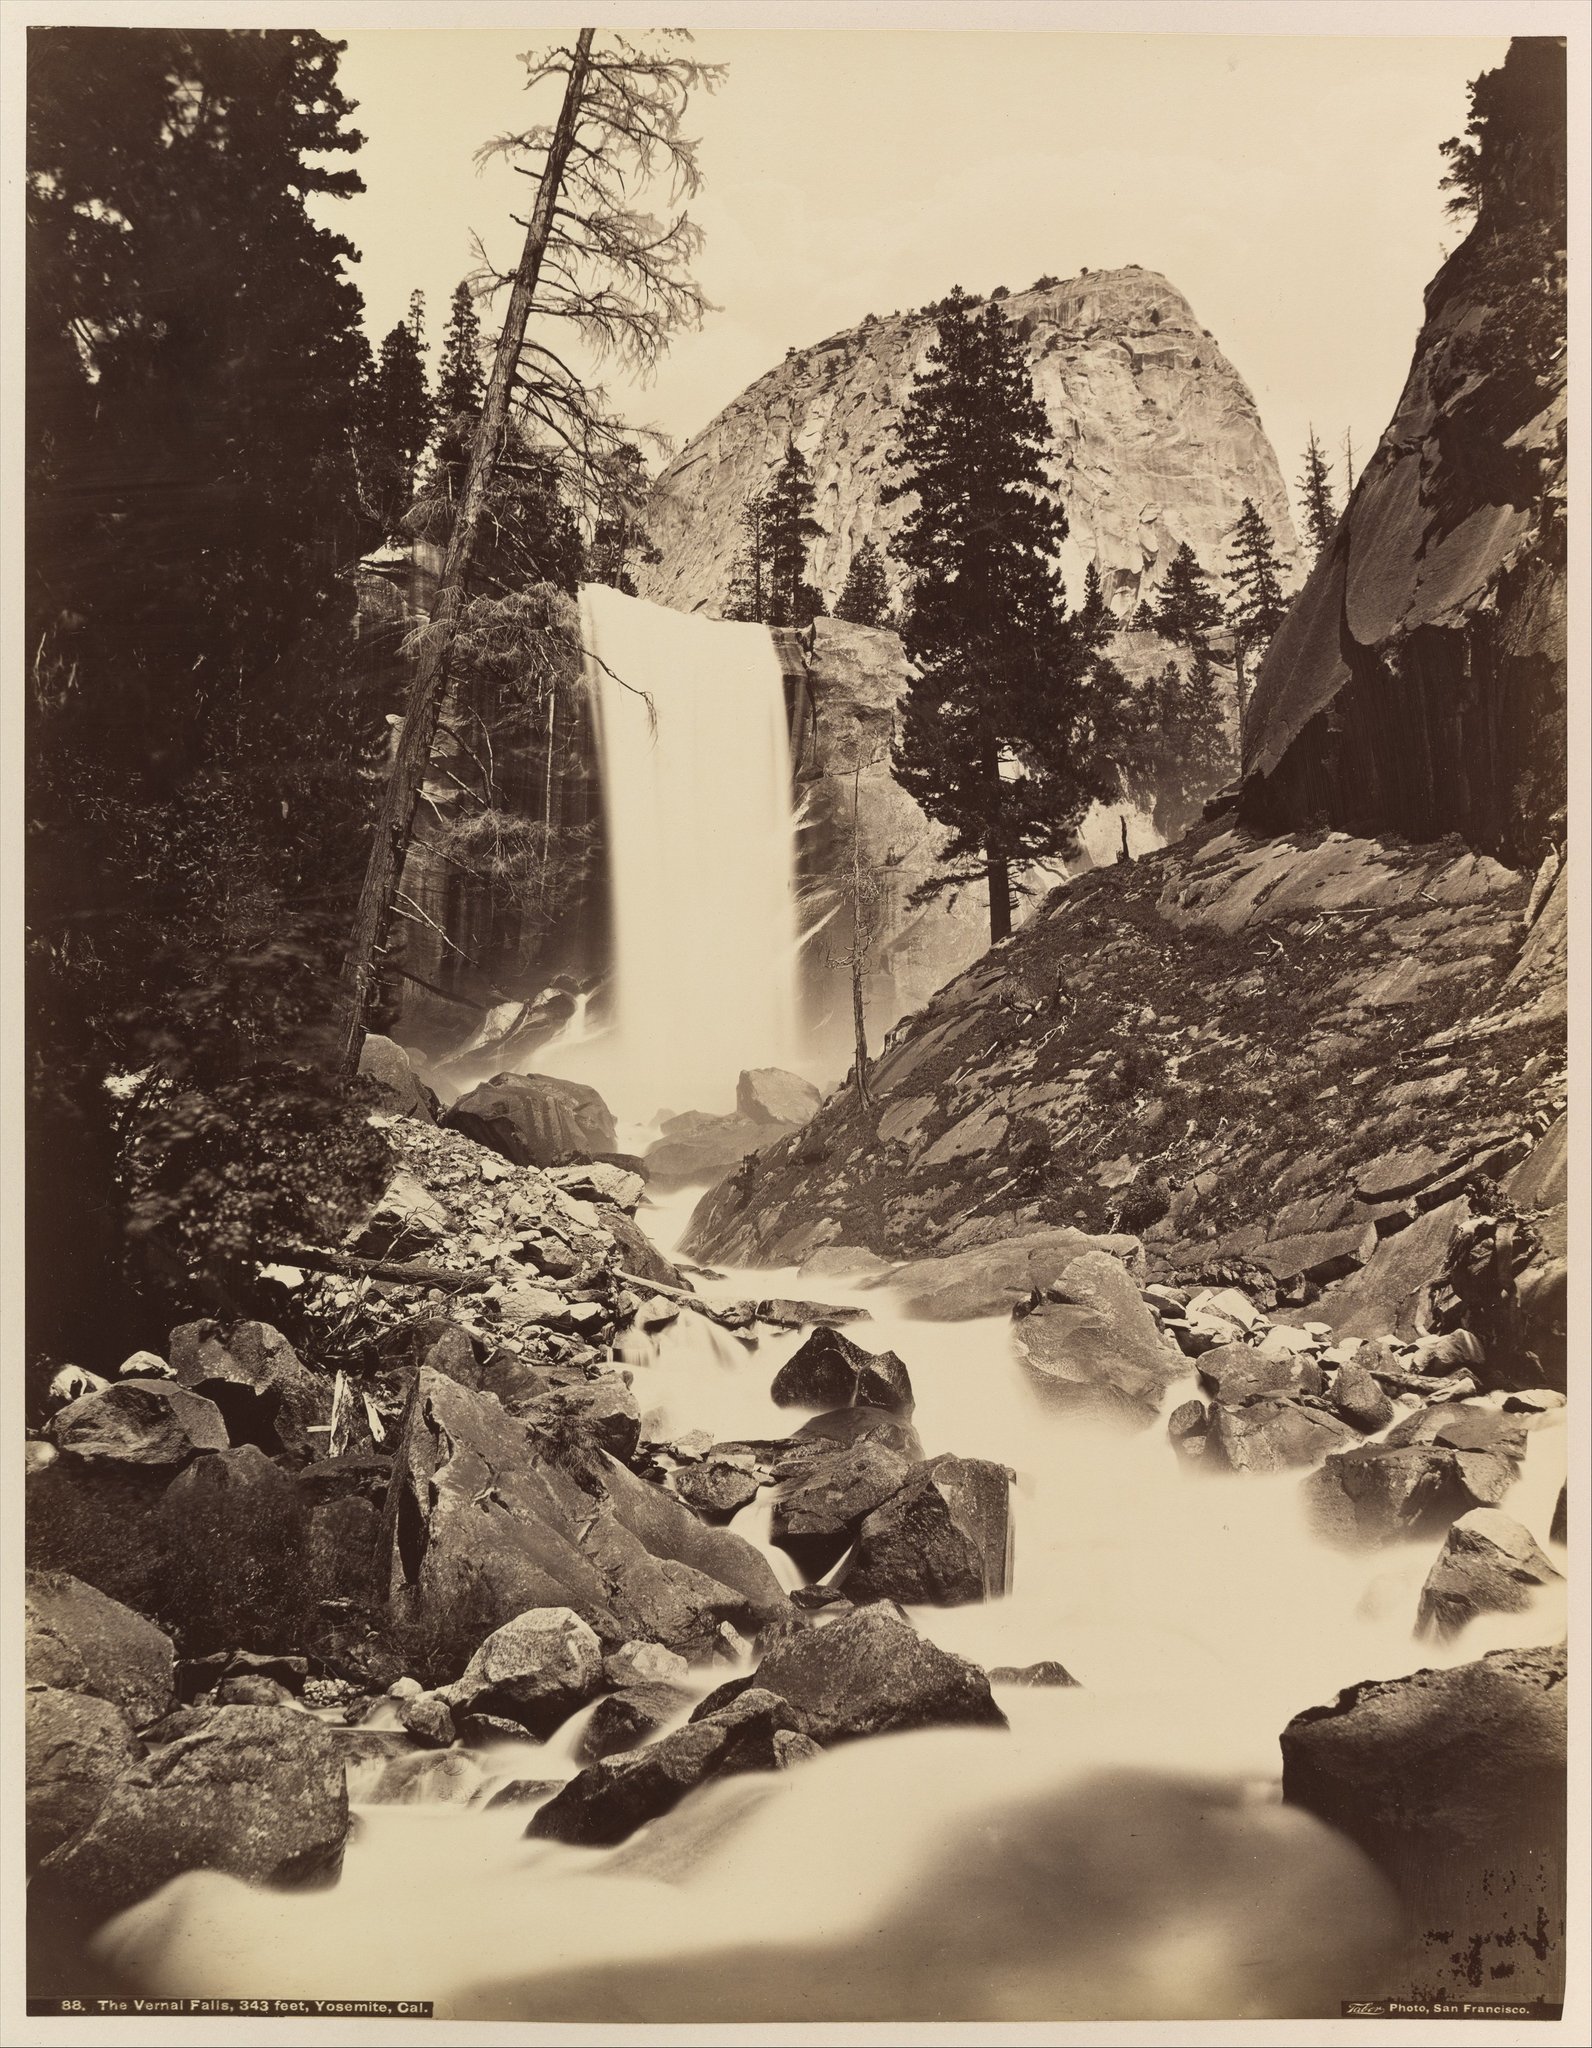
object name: photograph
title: Vernal Fall, Yosemite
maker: carleton e. watkins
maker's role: artist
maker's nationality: american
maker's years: 1829-1916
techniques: albumen silver print, glass negative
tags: waterfalls,mountains,landscapes